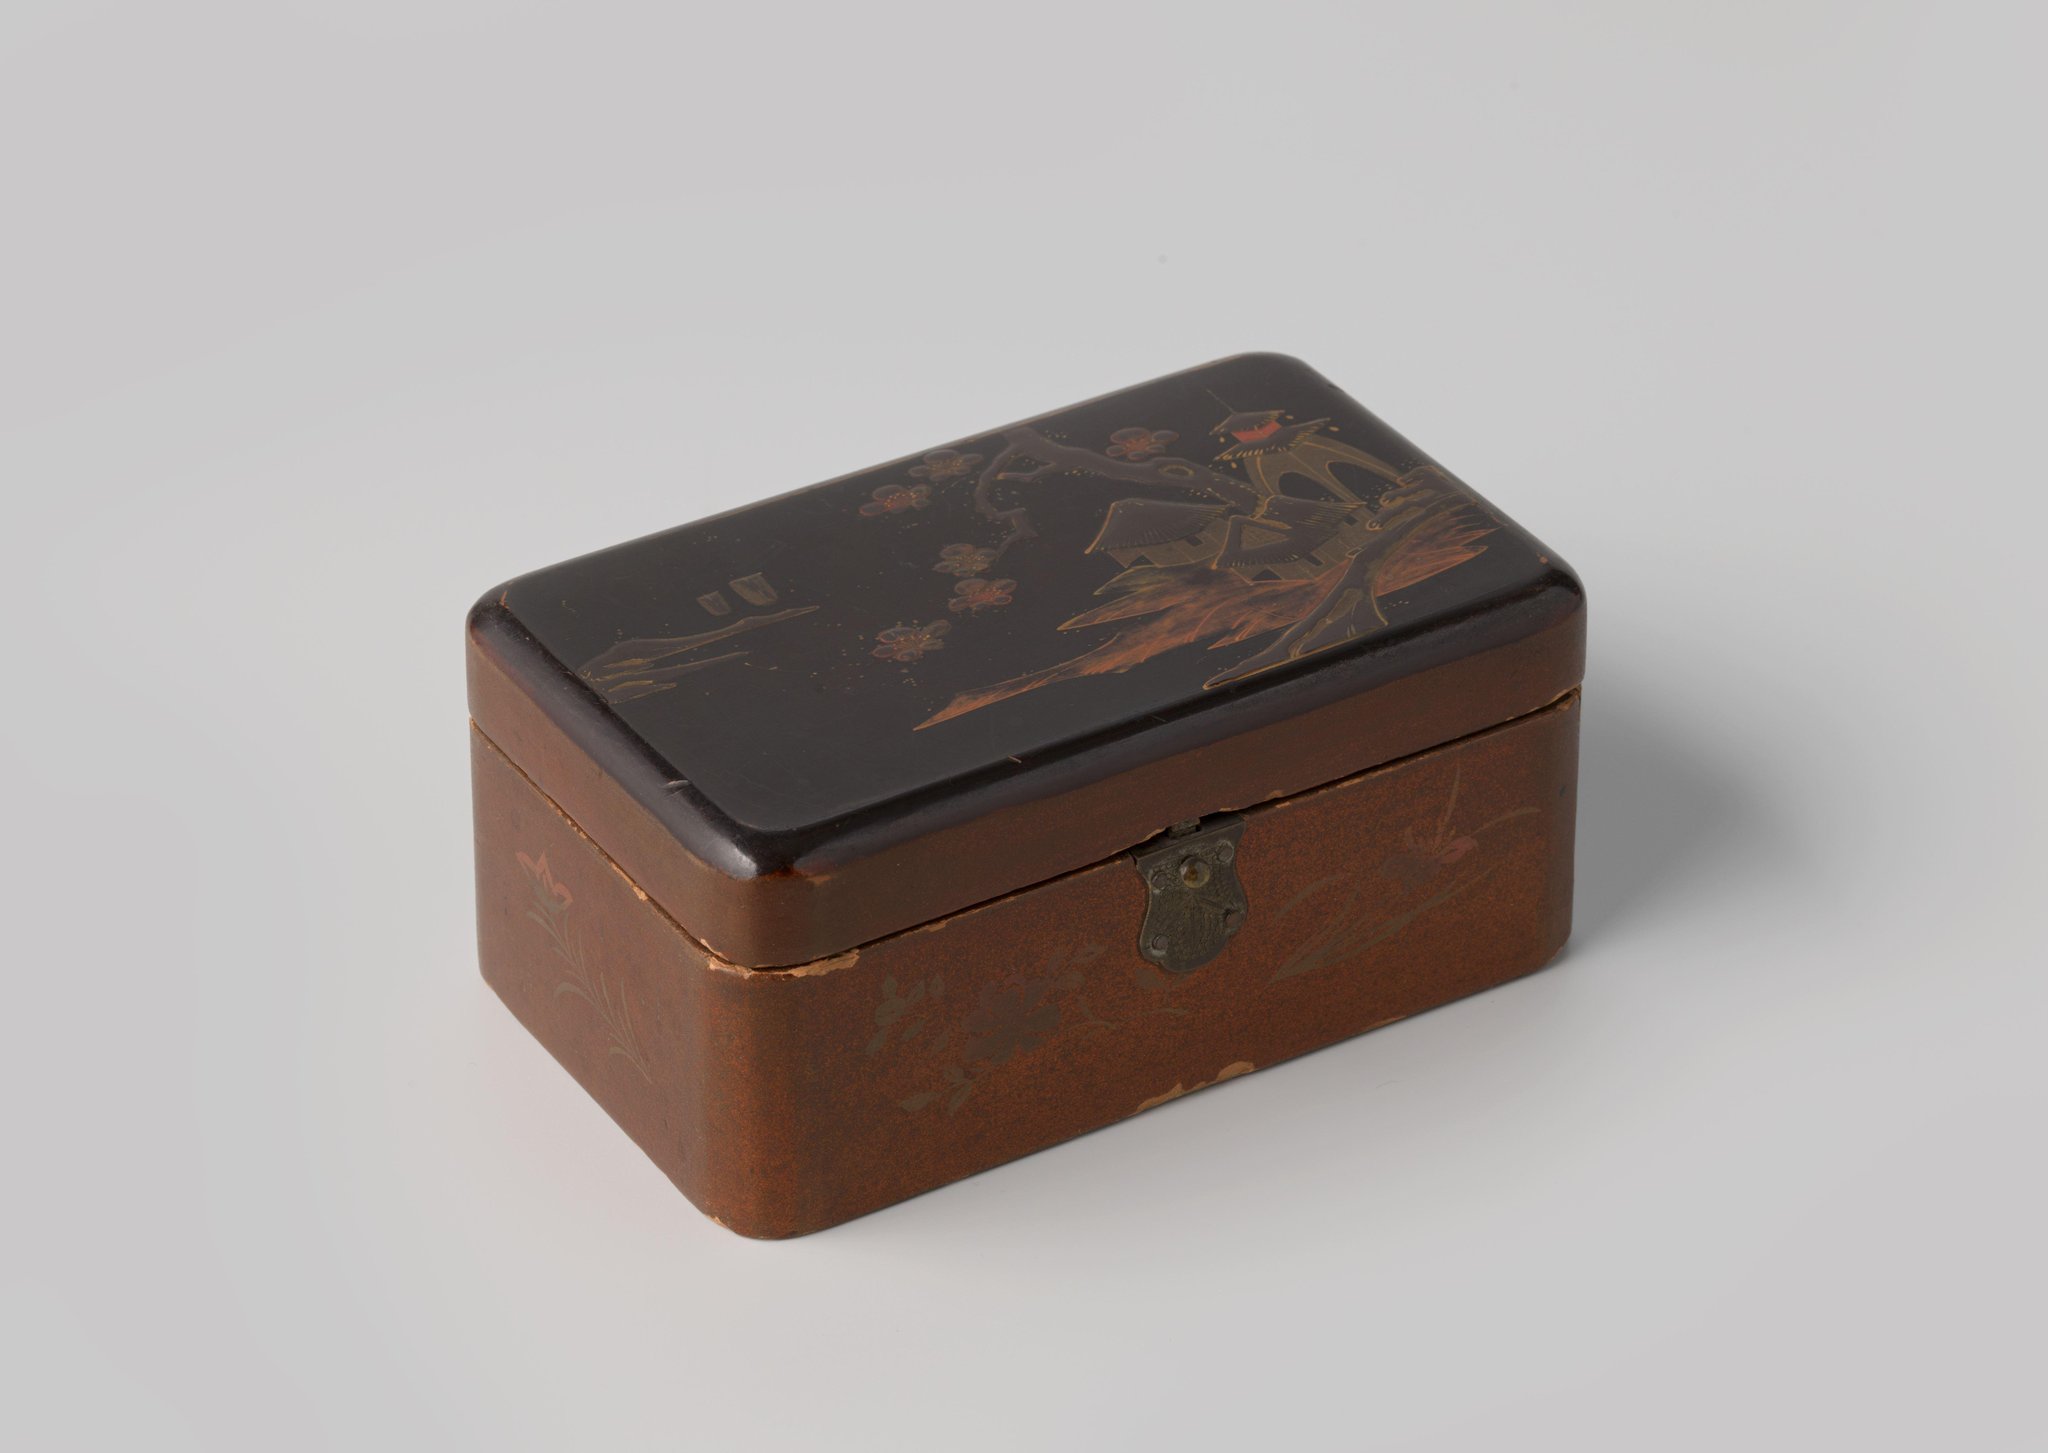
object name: box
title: Langwerpige doos van gelakt en geverfd hout met deksel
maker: Anonymous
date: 1900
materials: metal, paint, wood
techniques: lacquer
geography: netherlands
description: Langwerpige doos van gelakt en geverfd hout. Met metalen slot en scharnieren.